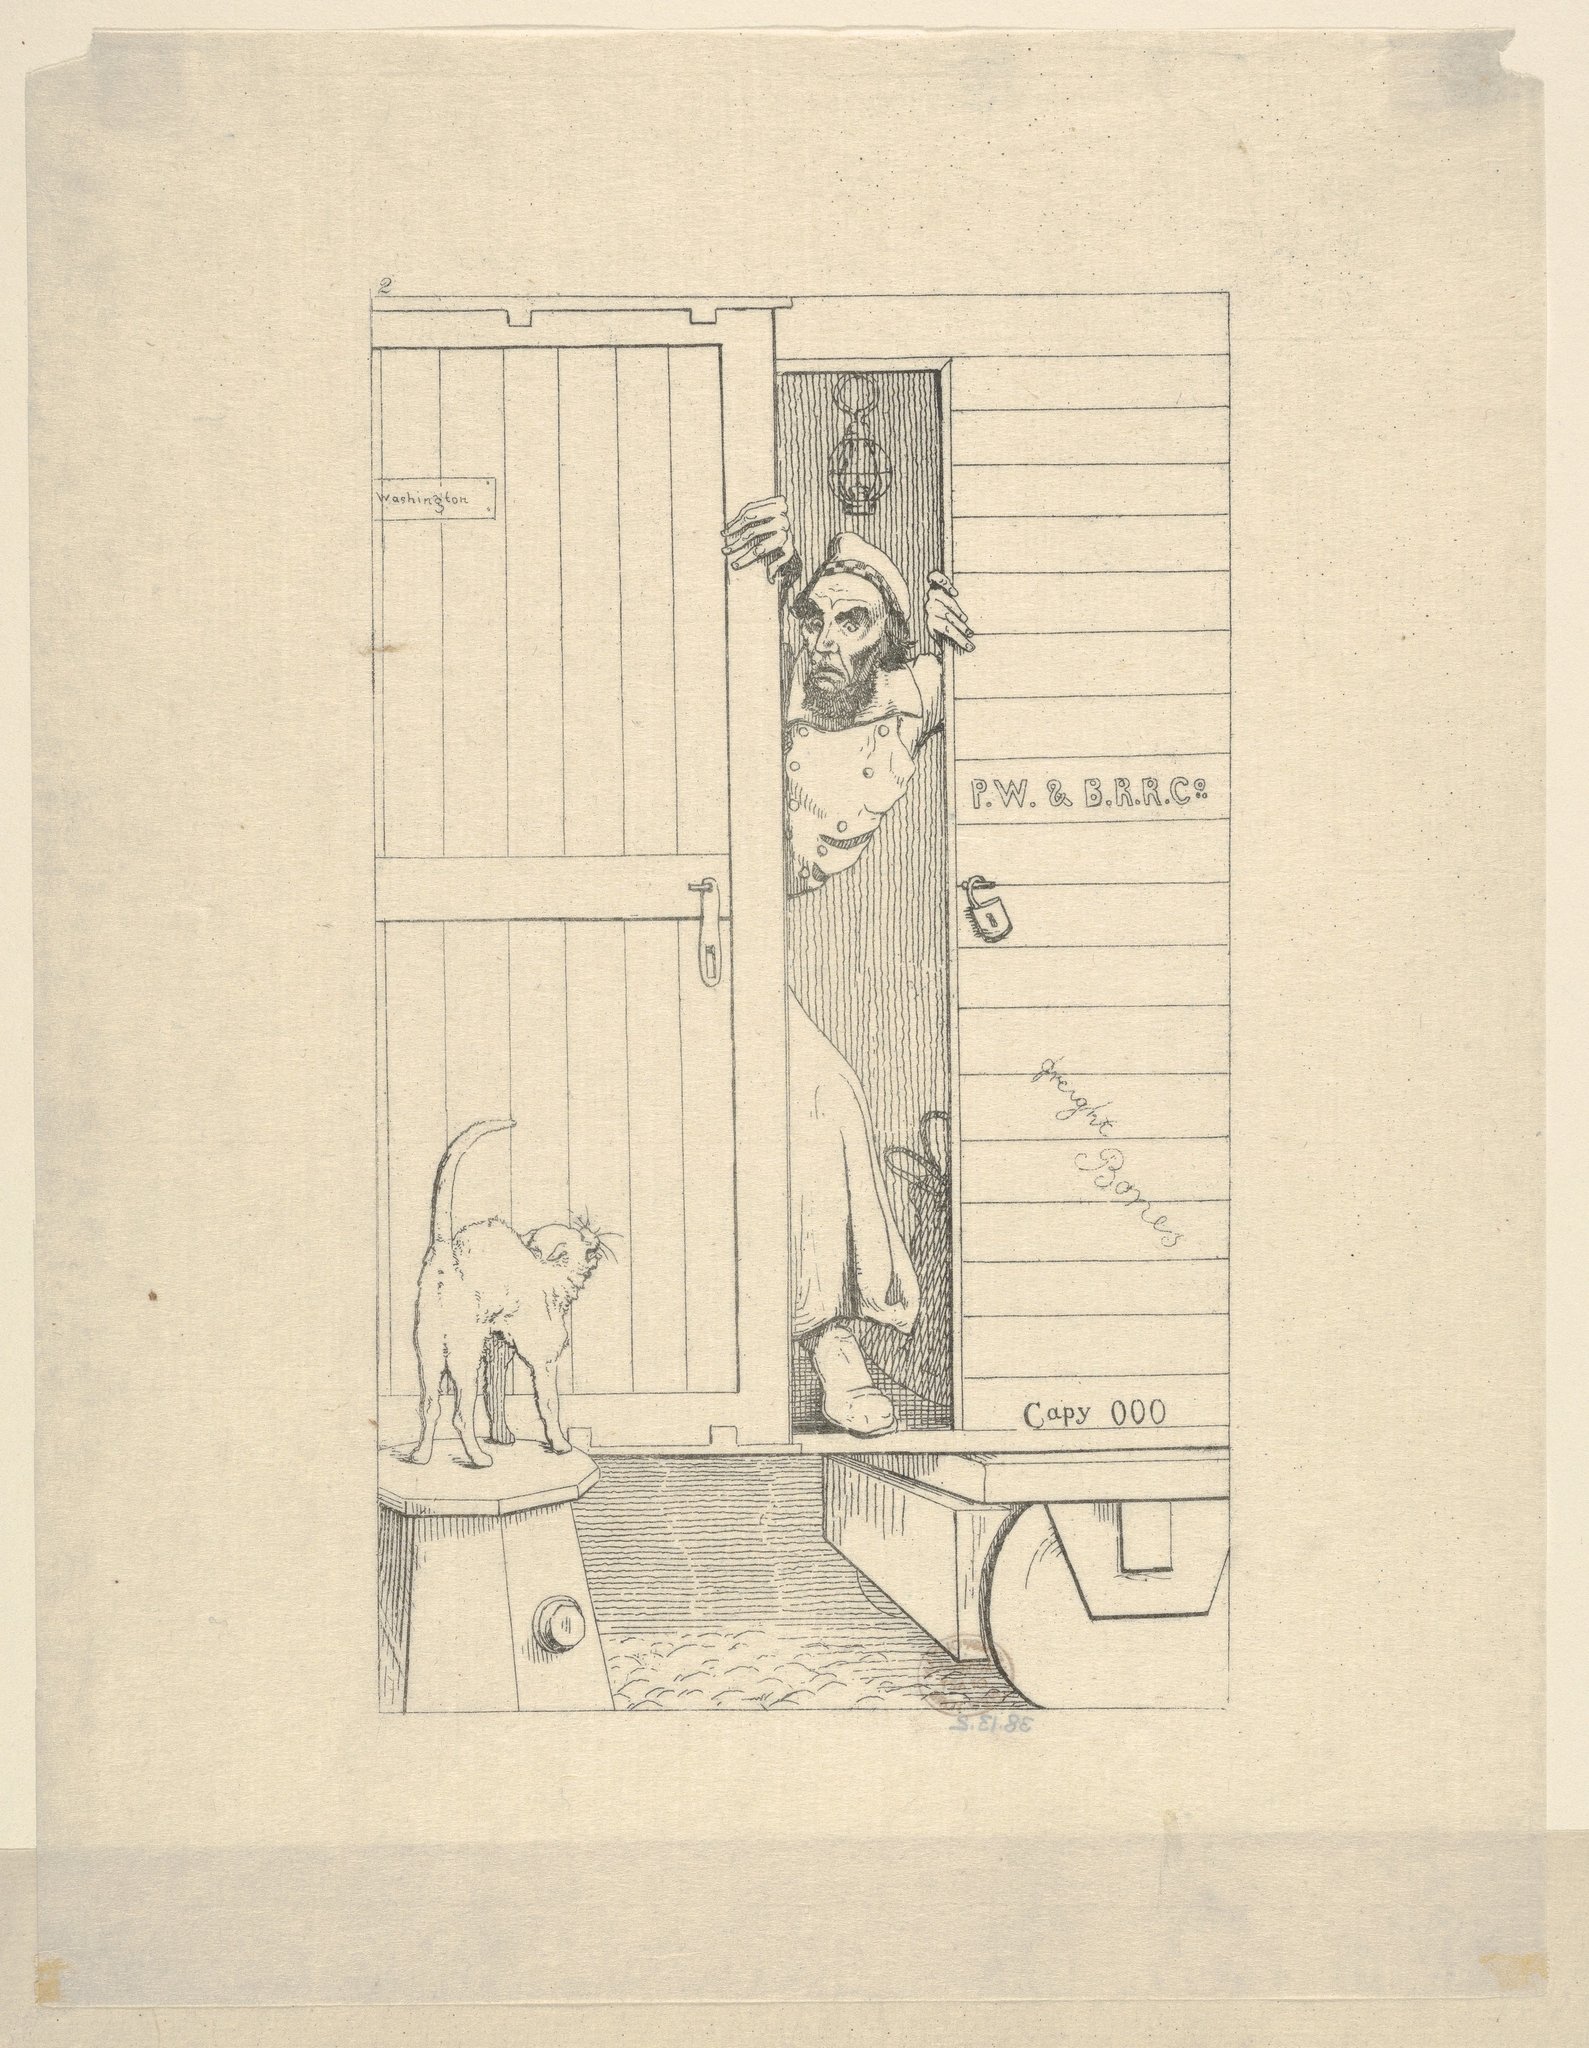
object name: print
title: Passage Through Baltimore (from Confederate War Etchings)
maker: adalbert john volck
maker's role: artist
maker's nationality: american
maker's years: 1828-1912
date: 1861-1863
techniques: etching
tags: american civil war,abraham lincoln,men,cats